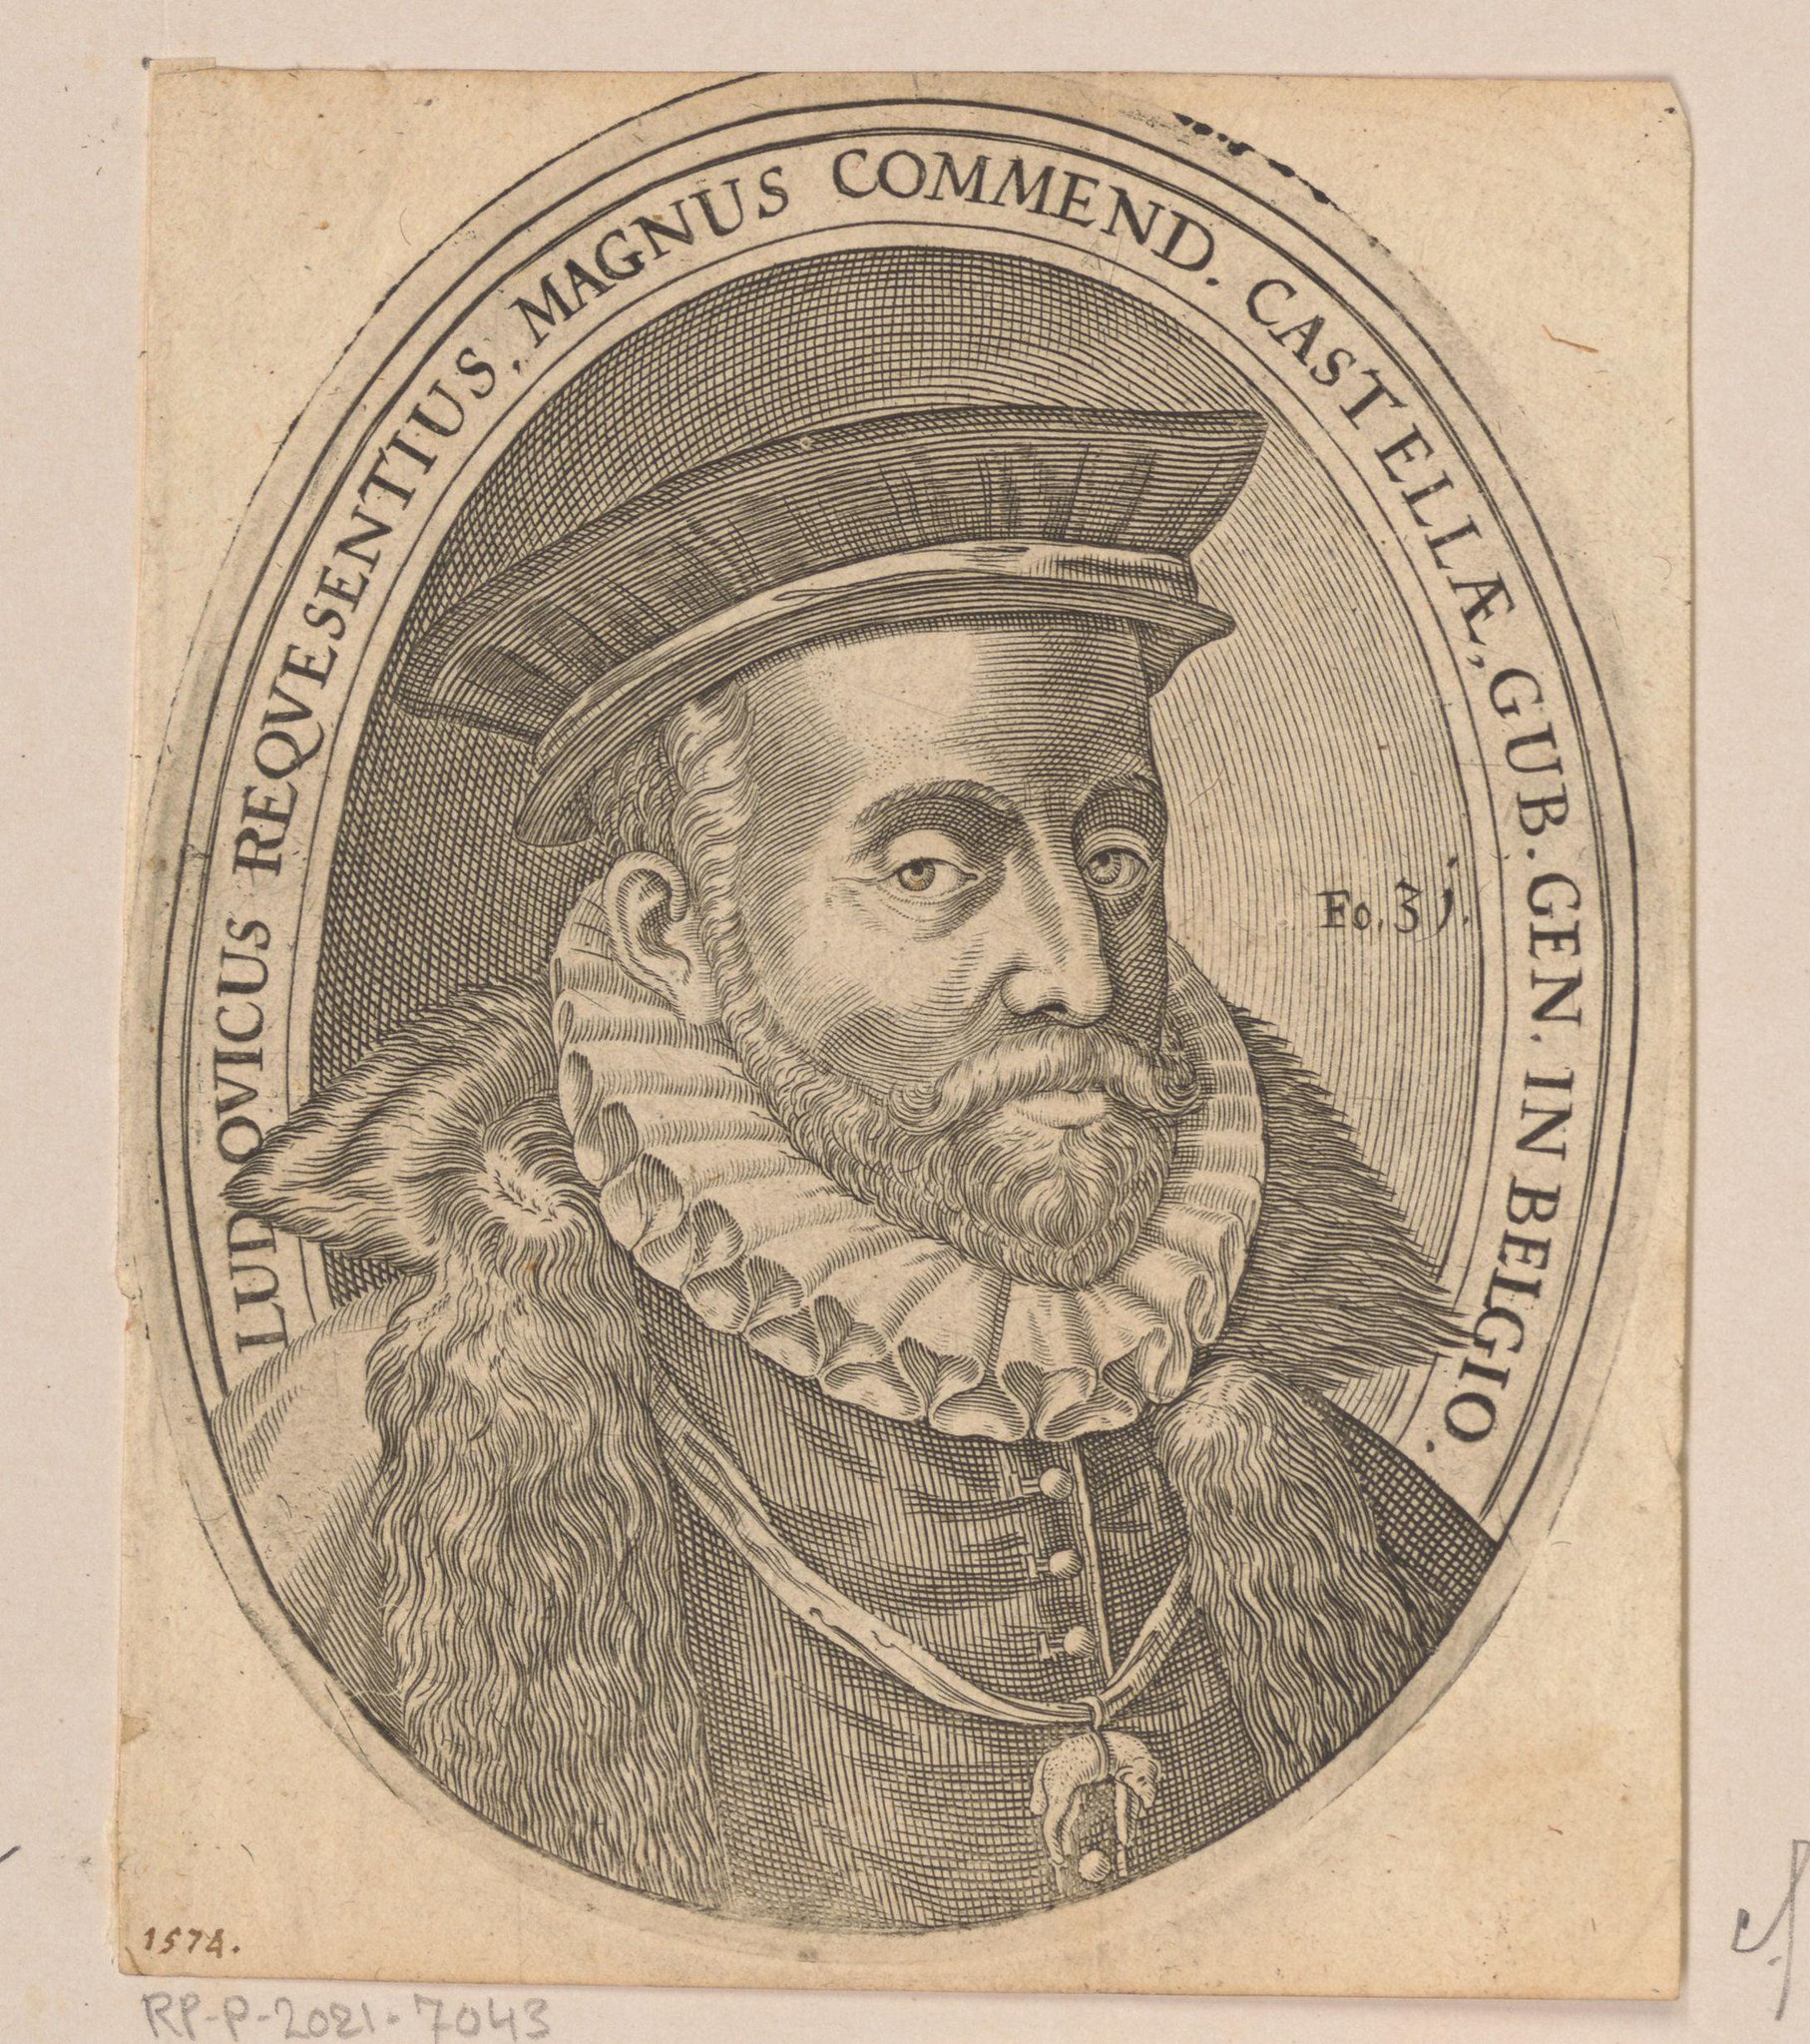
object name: print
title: Portret van Luis de Zúñiga y Requesens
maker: Anonymous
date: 1619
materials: paper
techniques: engraving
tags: brussels, mayor, luis de zúñiga y requesens, historical persons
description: Prent met tekst in boekdruk op recto en verso: Gysius, Johannes. Origo & historia Belgicorum tumultuum immanissimaeque crudelitatis per Cliviam & VVestphaliam (...). Leiden: Bartholomeus van der Bildt, 1619.